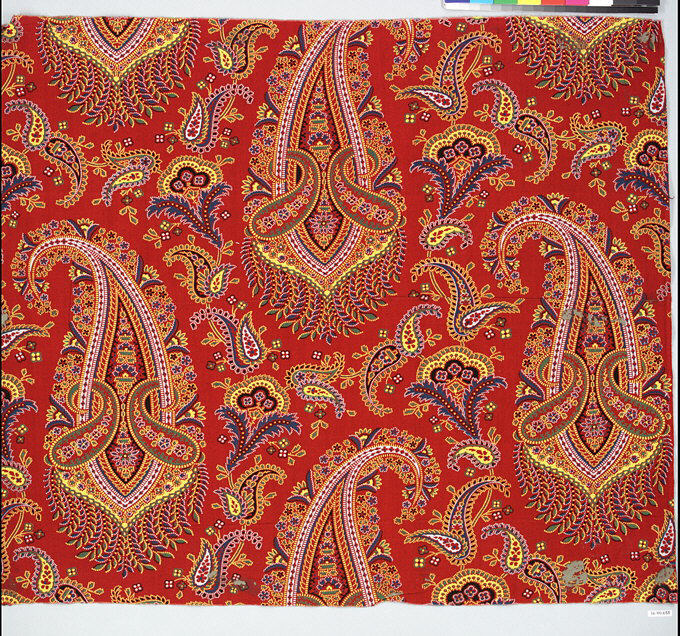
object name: piece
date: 1867-1900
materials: cotton